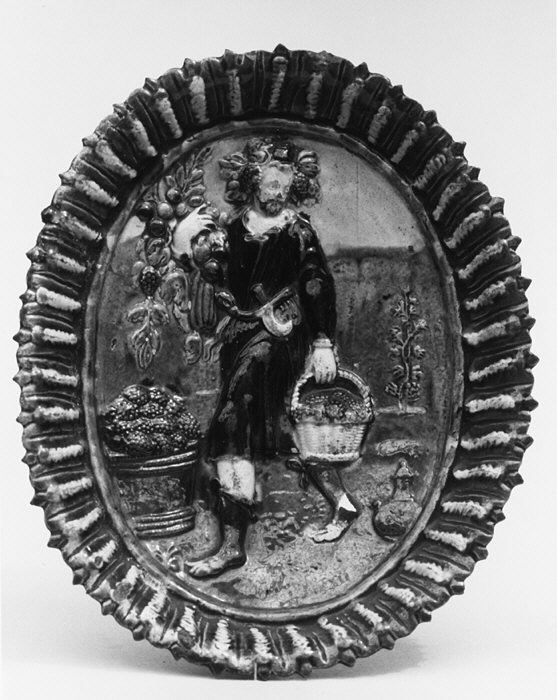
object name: dish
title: Dish with Allegory of Autumn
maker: bernard palissy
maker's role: maker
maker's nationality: french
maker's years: 1510-1590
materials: earthenware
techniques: glazing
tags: food,fruit,grapes,wine,men,walking,autumn,harvesting